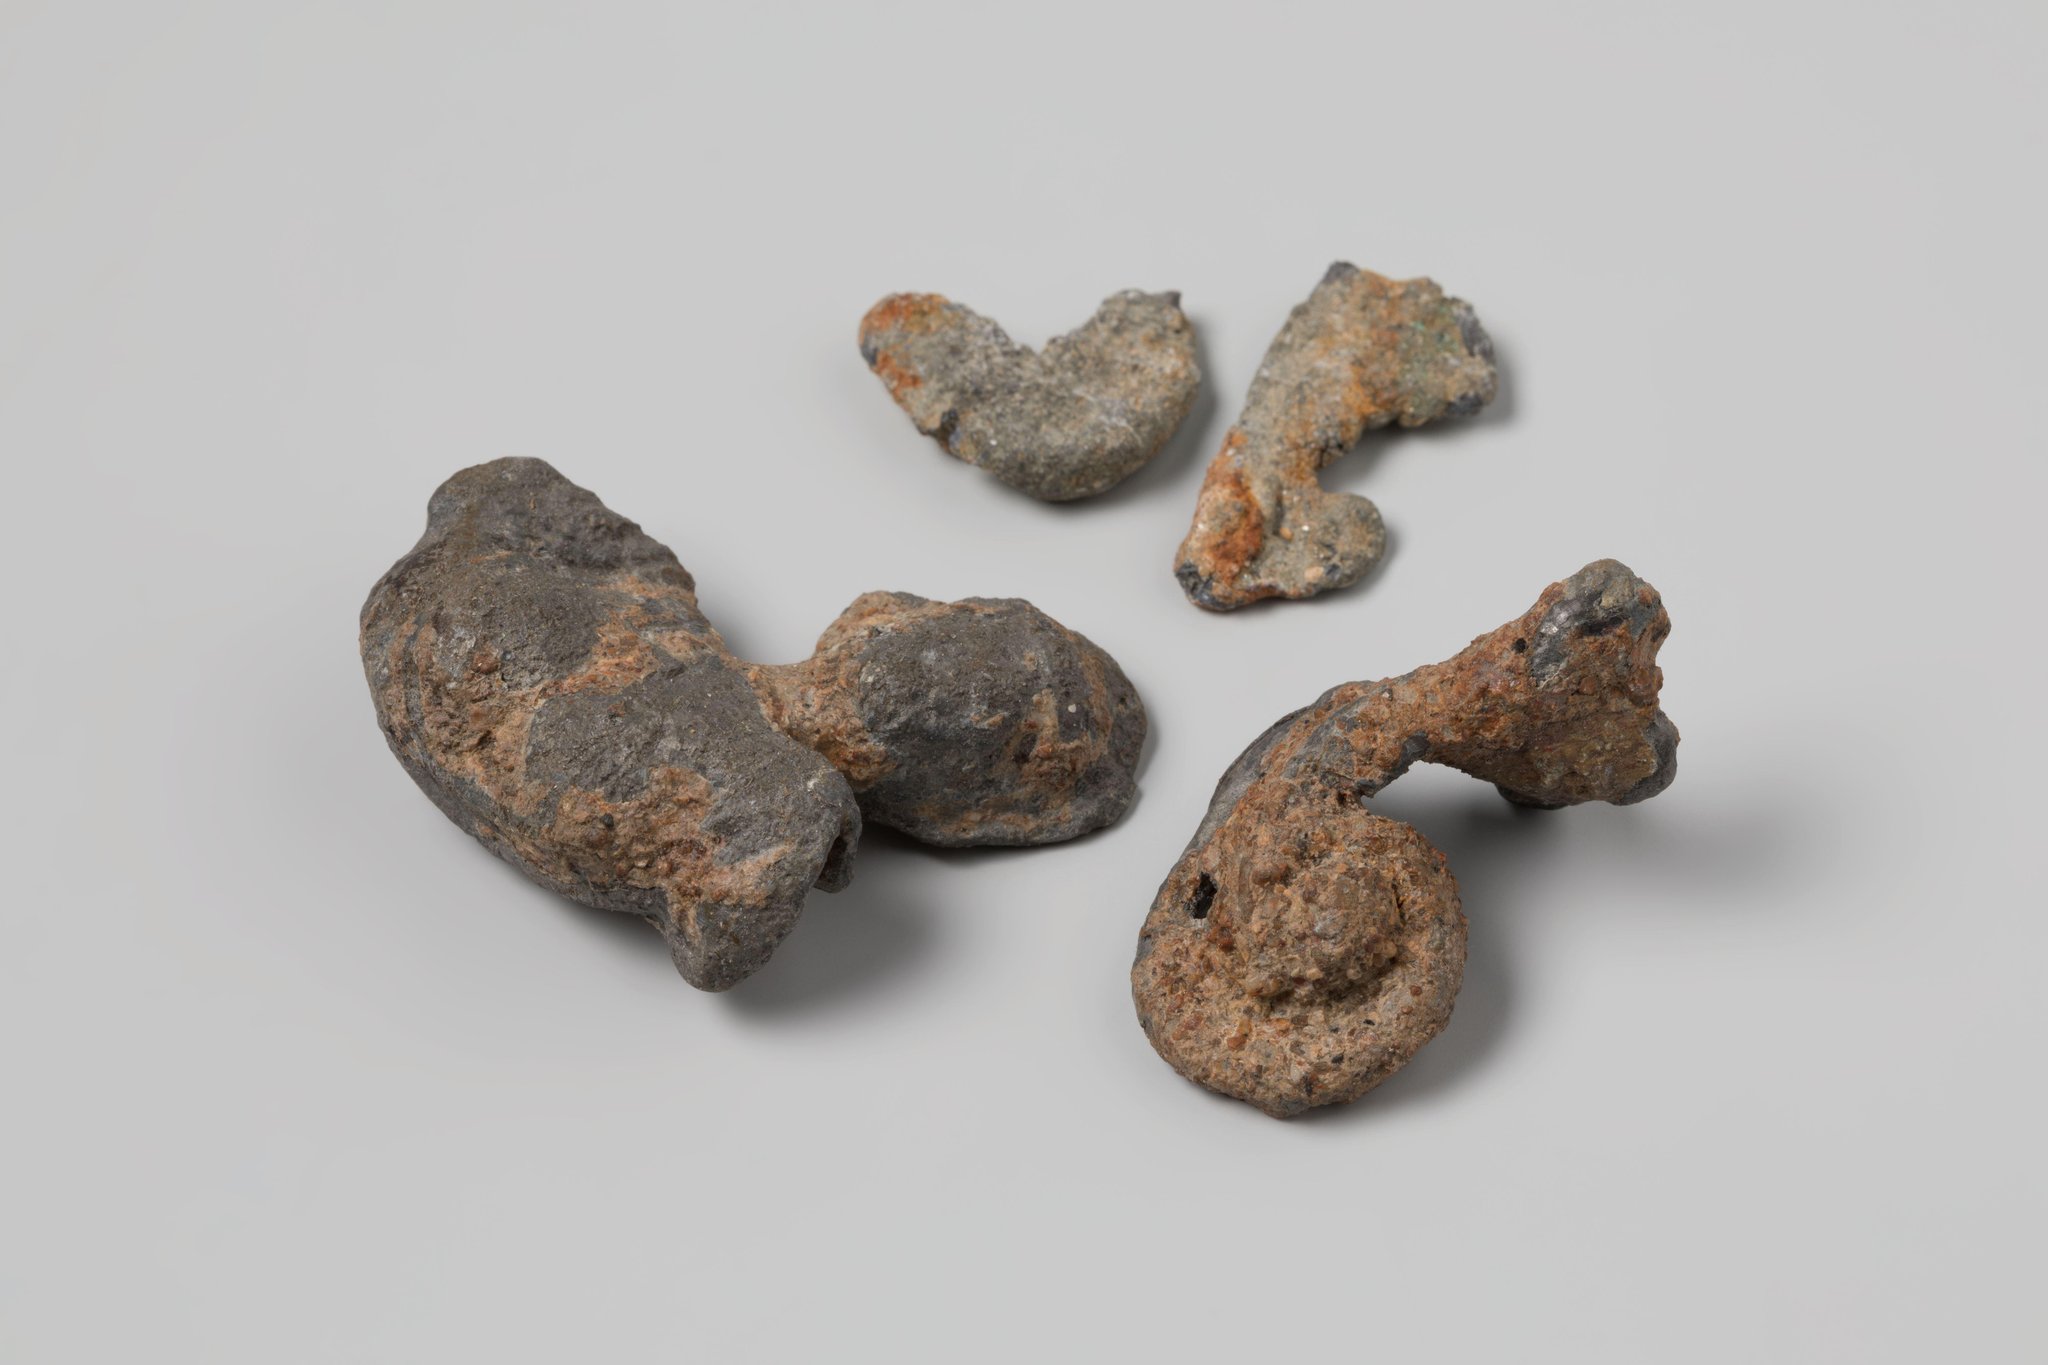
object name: beslag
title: Decoratief beslag uit het wrak van de Oost-Indiëvaarder Hollandia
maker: Anonymous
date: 1700-1743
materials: lead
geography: netherlands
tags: verenigde oostindische compagnie, hollandia (schip), annet